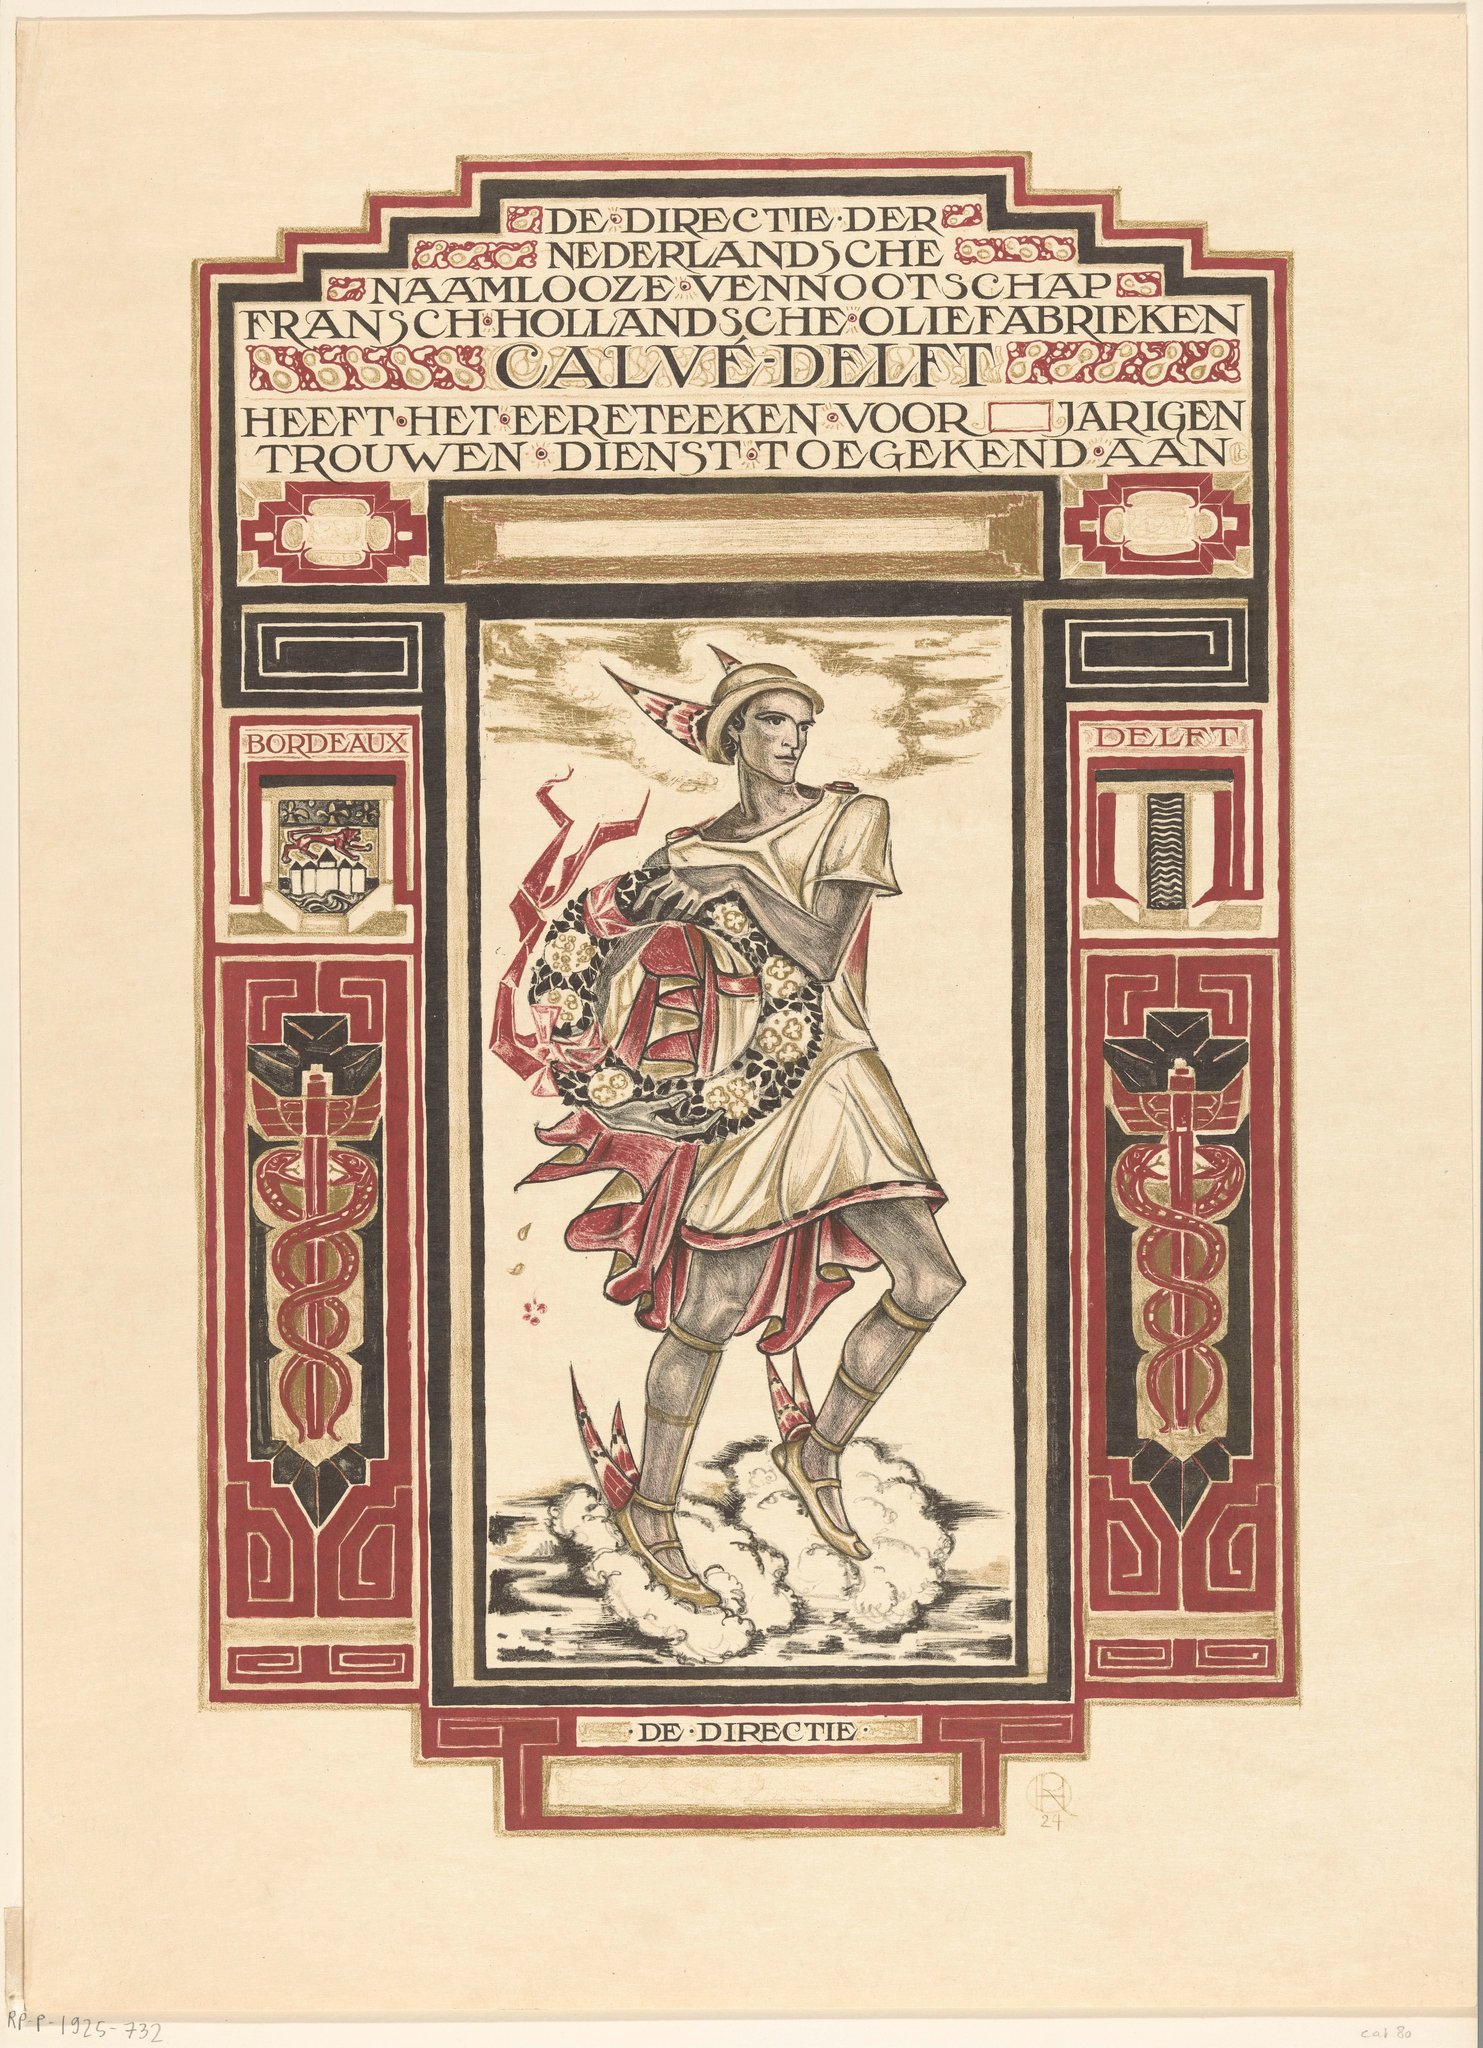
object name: design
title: Ontwerp voor: Diploma voor trouwe dienst bij Calvé-Delft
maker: richard nicolaüs roland holst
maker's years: 1868-1938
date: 1924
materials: paper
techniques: lithograph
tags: garland, wreath, (story of) mercury (hermes)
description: Hermes, herkenbaar aan zijn gevleugelde sandalen en petasus (hoed), die een bloemenkrans vasthoudt. Om het geheel een kader met links en rechts een zogenaamde caduceus, een door twee slangen omwonden staf, en de stadswapens van Delft en Bordeaux. Bovenaan de tekst 'De directie der Nederlandsche Naamloze Vennootschap Fransch-Hollandsche Oliefabrieken Calvé-Delft heeft het eereteeken voor [...] jarigen trouwen dienst toegekend aan [...]'.